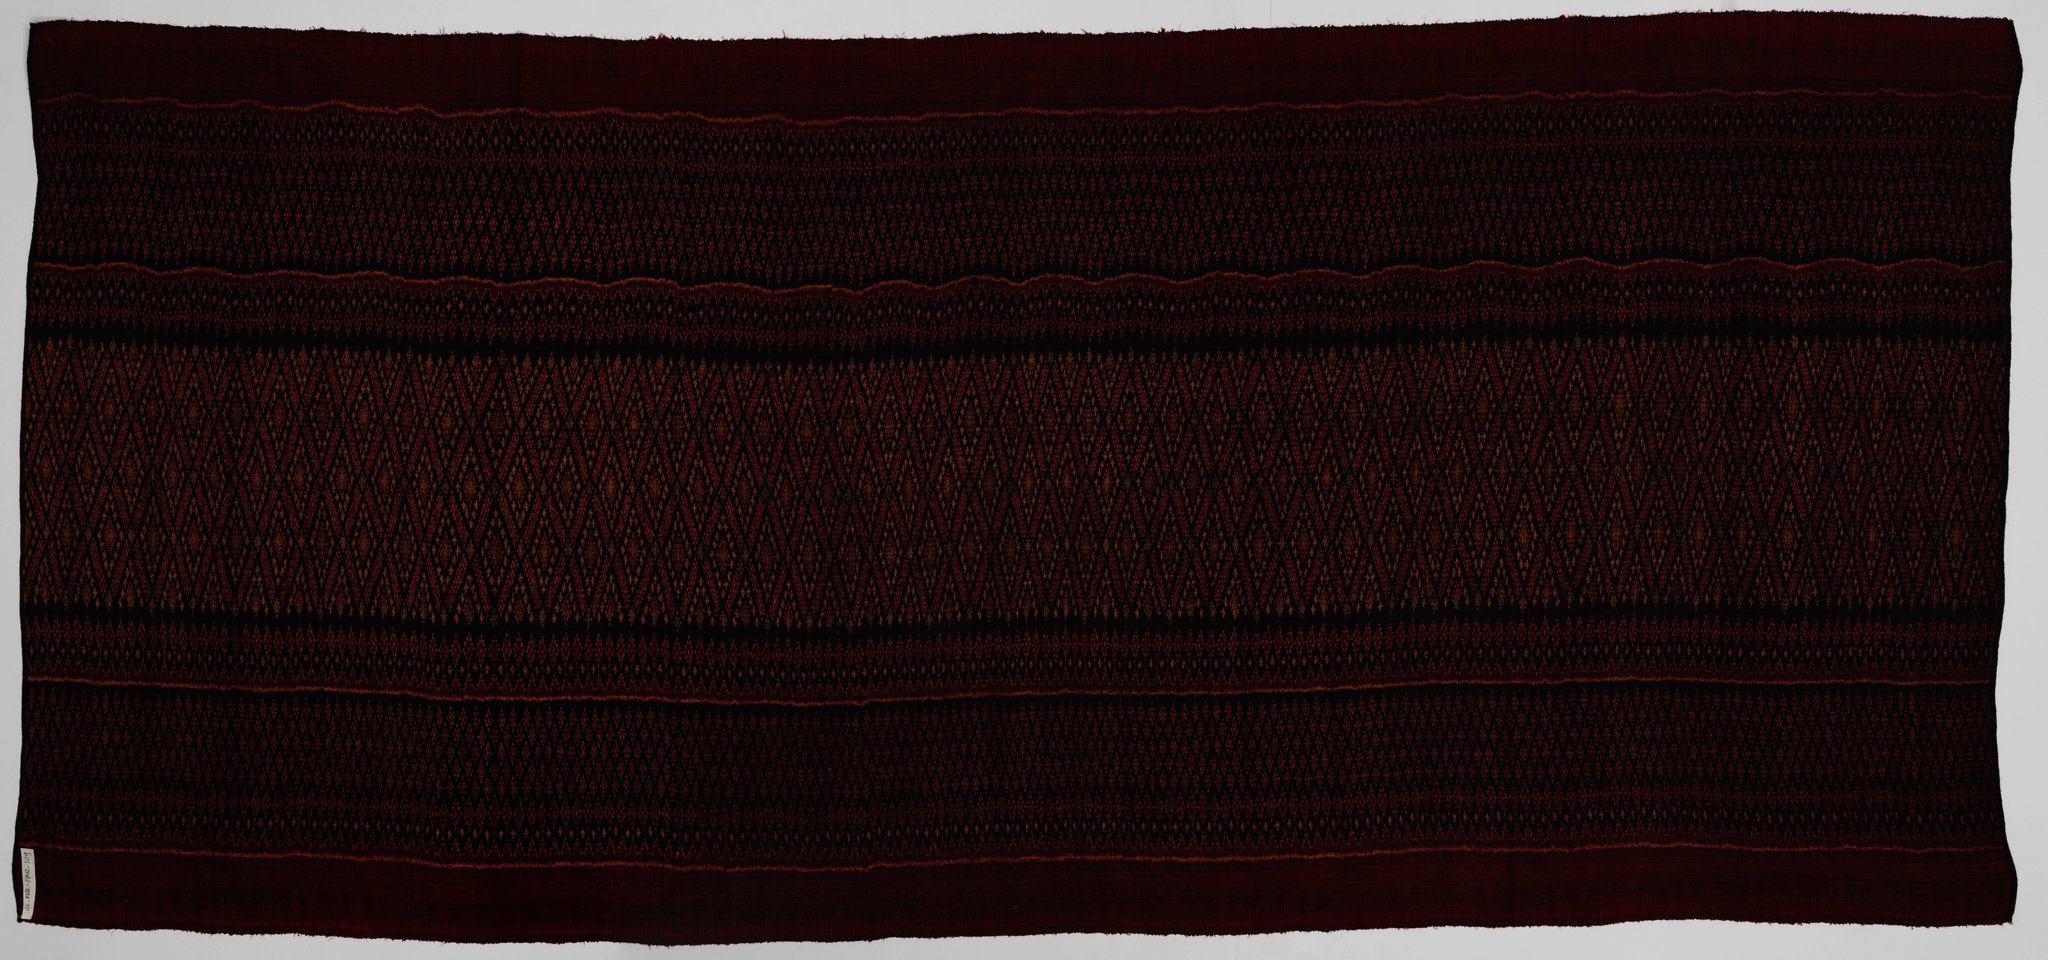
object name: heupdoek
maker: Anonymous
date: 1900-1949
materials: silk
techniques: weave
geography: thailand